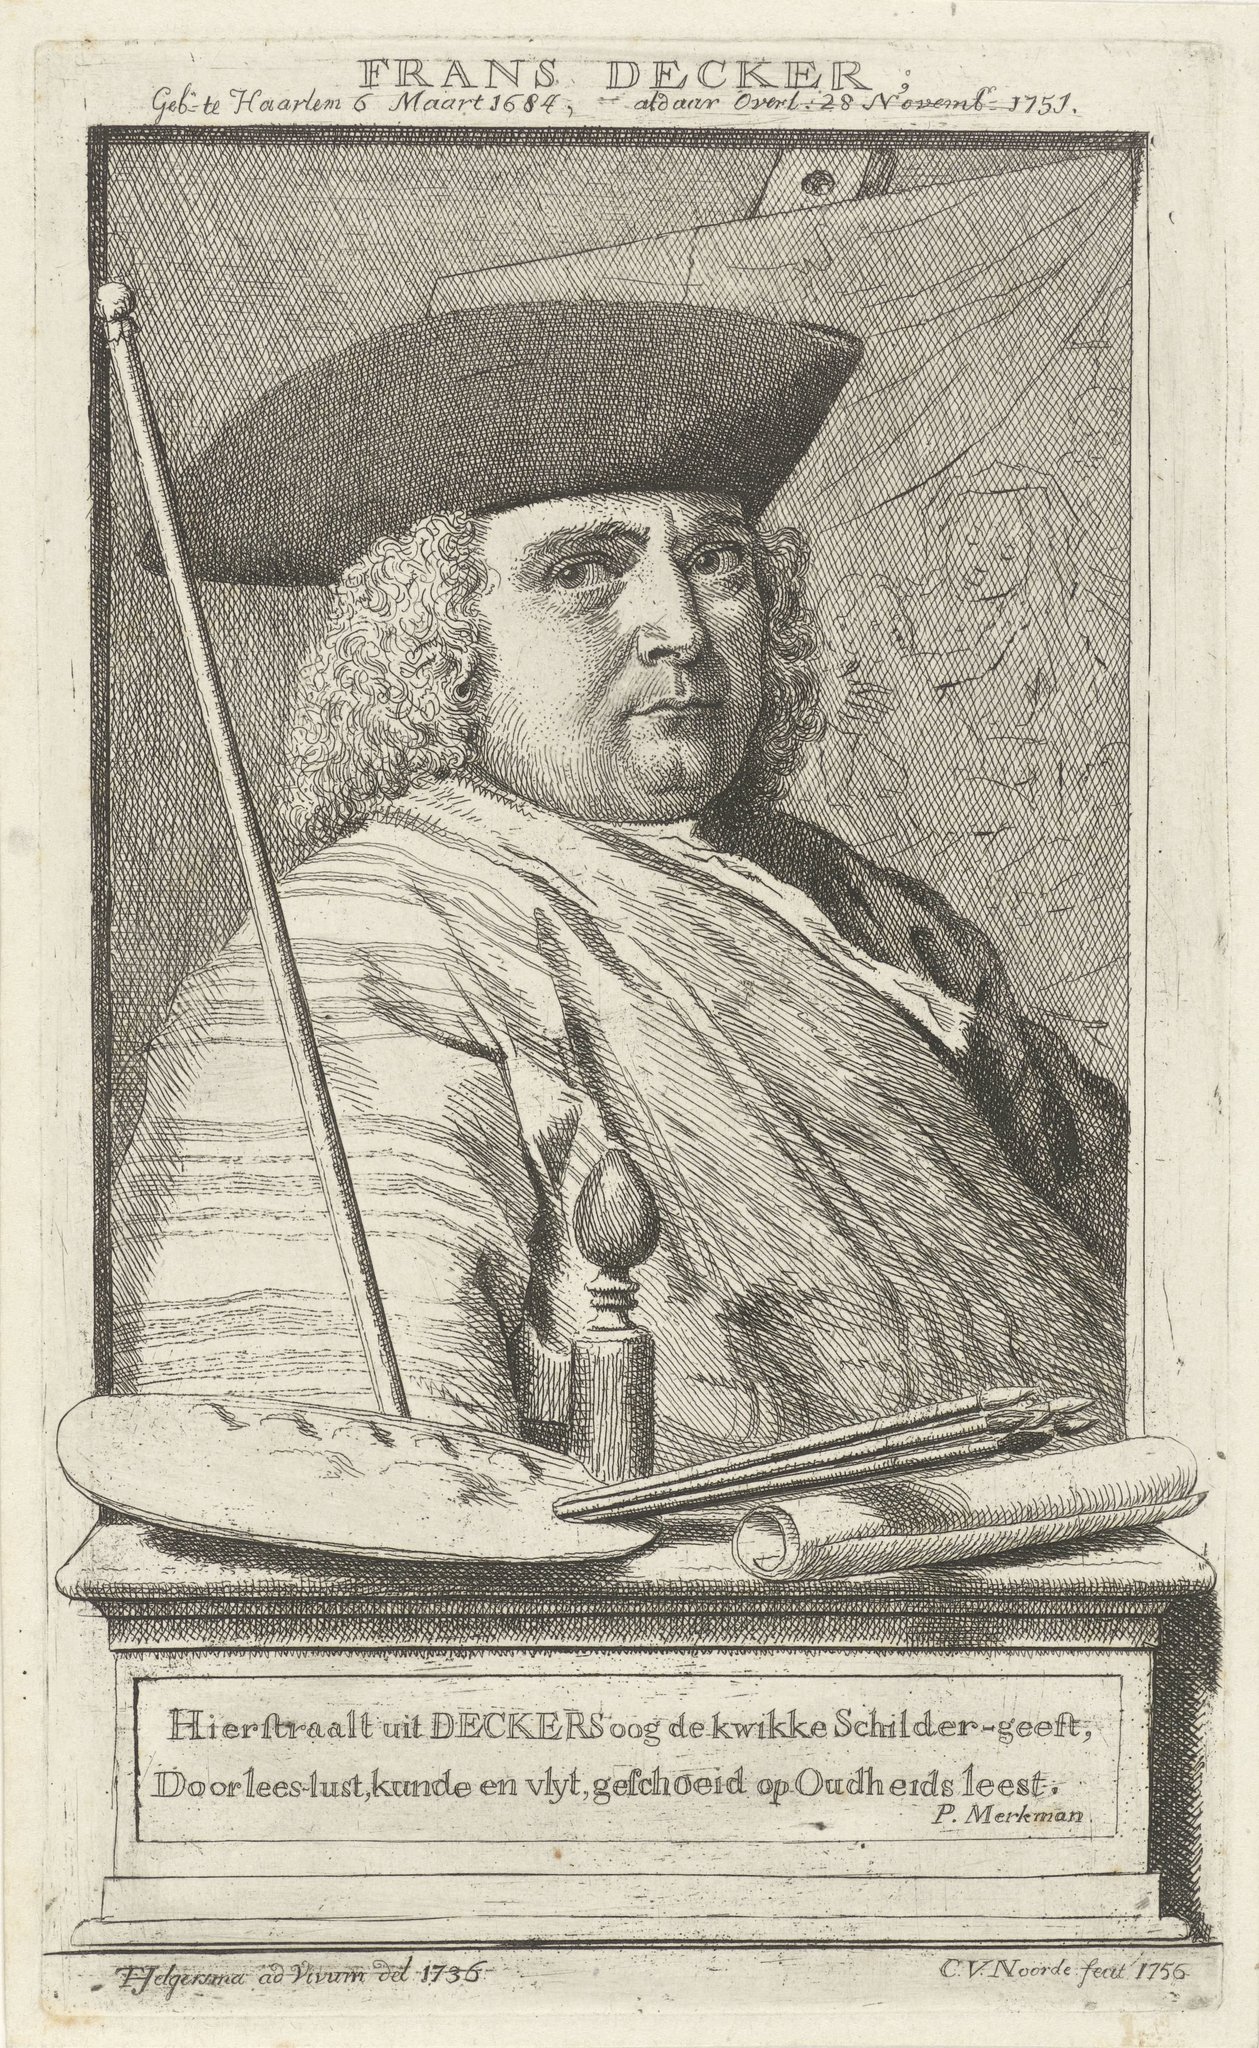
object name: print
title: Portret van Frans Decker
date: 1756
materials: paper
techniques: engraving, etching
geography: haarlem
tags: haarlem, painter, draughtsman, frans decker, tools, implements of painter, portrait, self-portrait of artist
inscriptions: collector's mark: Lugt 240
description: Portret van de schilder Frans Decker. Voor het portret liggen schilderstok, palet en penselen. Achter Decker staat een schildersezel met een schilderij van Madonna met kind.